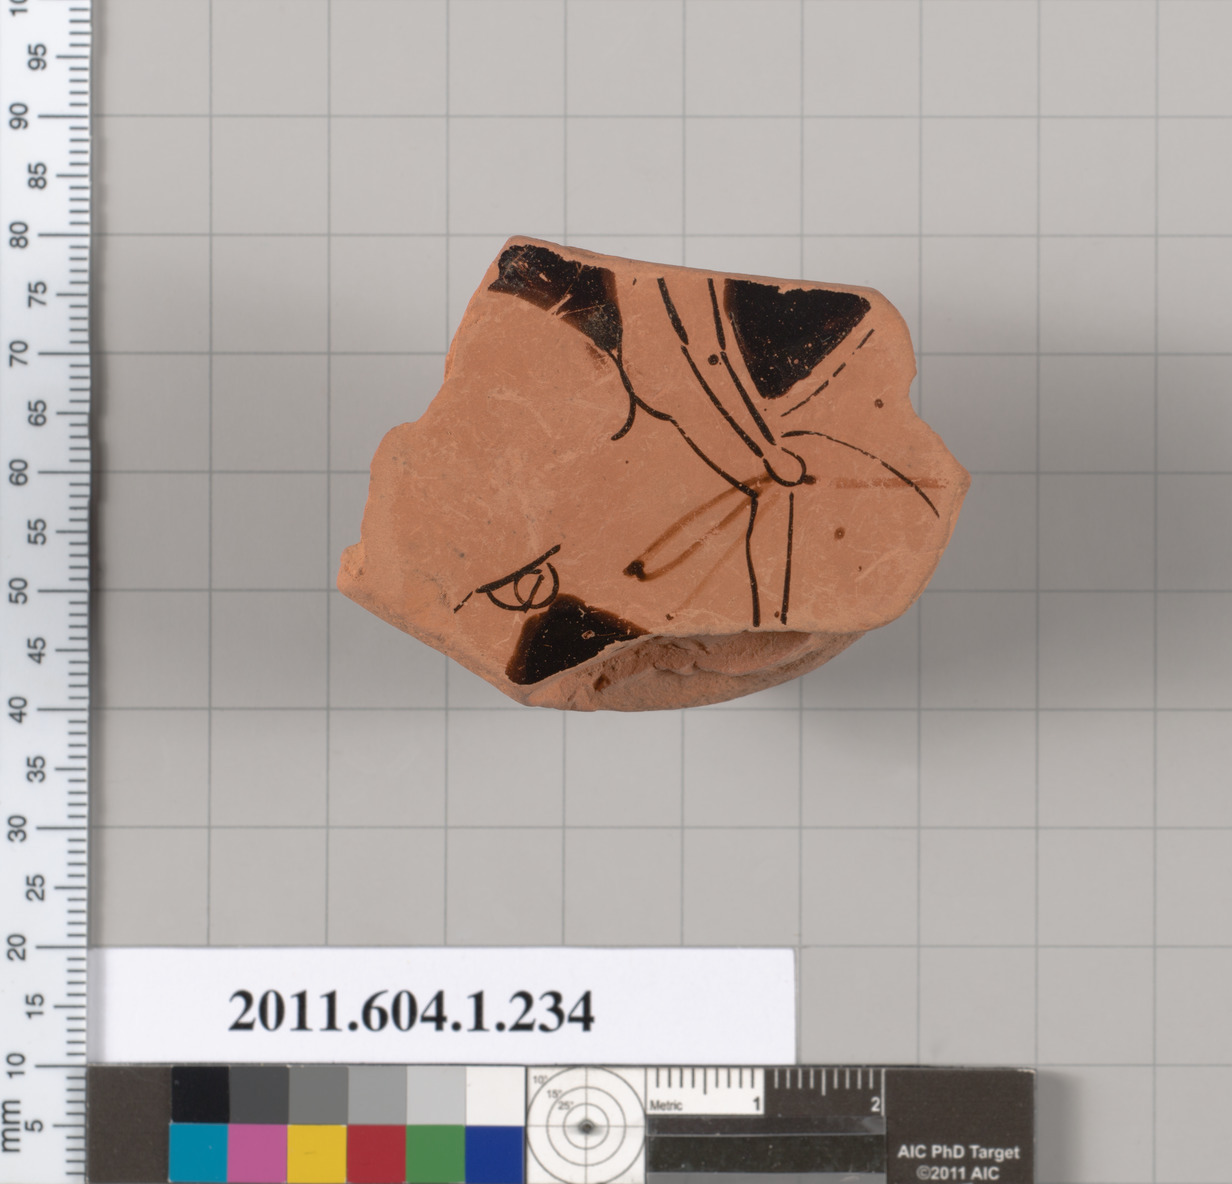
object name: kylix fragment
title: Terracotta fragment of a kylix (drinking cup)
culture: greek, attic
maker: angular painter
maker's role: artist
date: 475-451 BCE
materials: terracotta